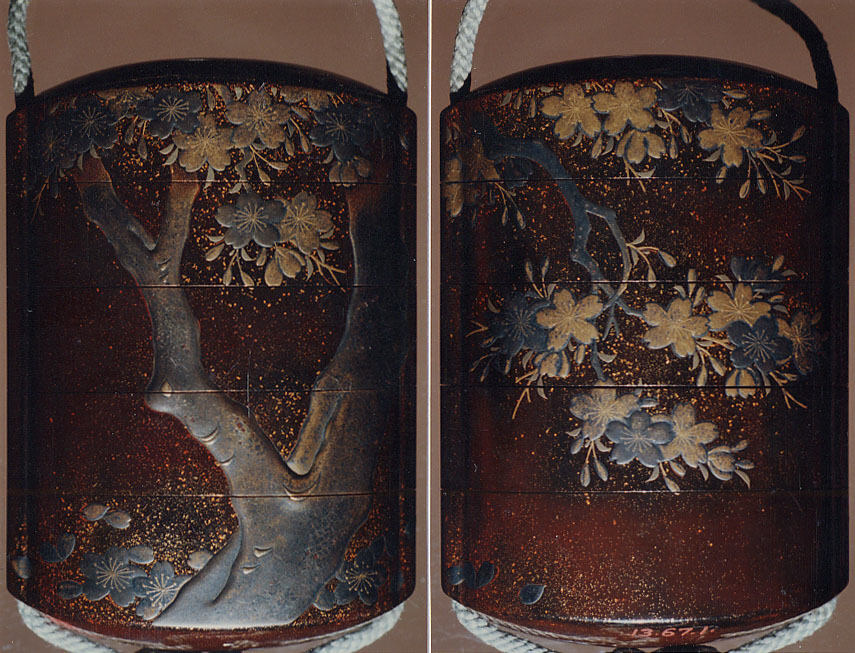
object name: inrō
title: Case (Inrō) with Design of a Flowering Cherry Tree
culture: japanese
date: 1801-1900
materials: gold, lacquer, silver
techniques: fundame, hiramakie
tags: flowers,trees